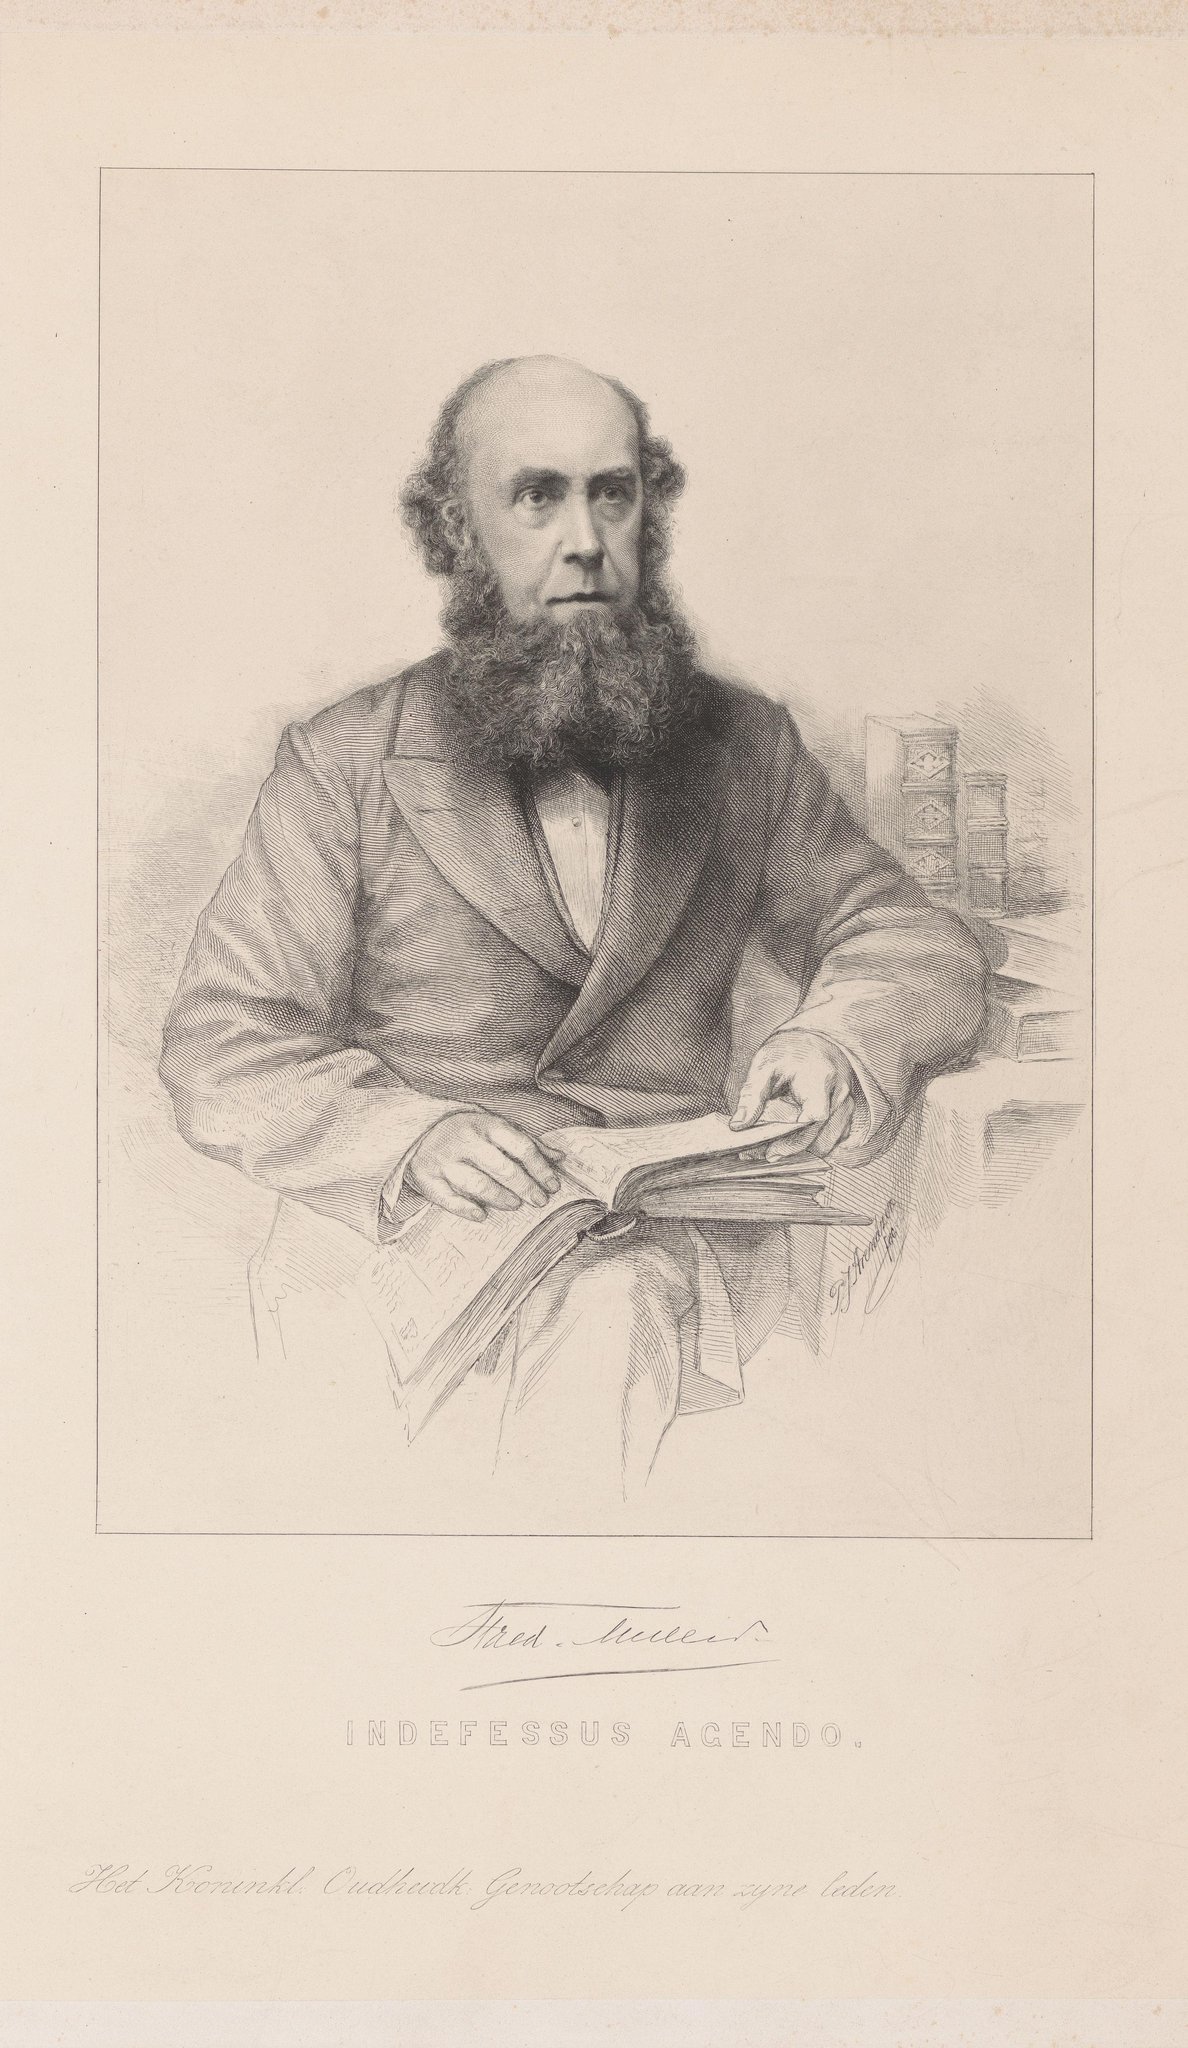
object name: print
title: Portret van Frederik Muller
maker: petrus johannes arendzen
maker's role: draughtsman, print maker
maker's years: 1846-1932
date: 1879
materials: paper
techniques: etching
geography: netherlands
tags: amsterdam, bookseller, frederik muller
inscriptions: collector's mark: Lugt 2228, collector's mark: Lugt 4780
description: Portret van Frederik Muller op 62 jarige leeftijd, bij een tafel met boeken. Onder het portret zijn handtekening in facsimile en het motto: Indefessus agendo.